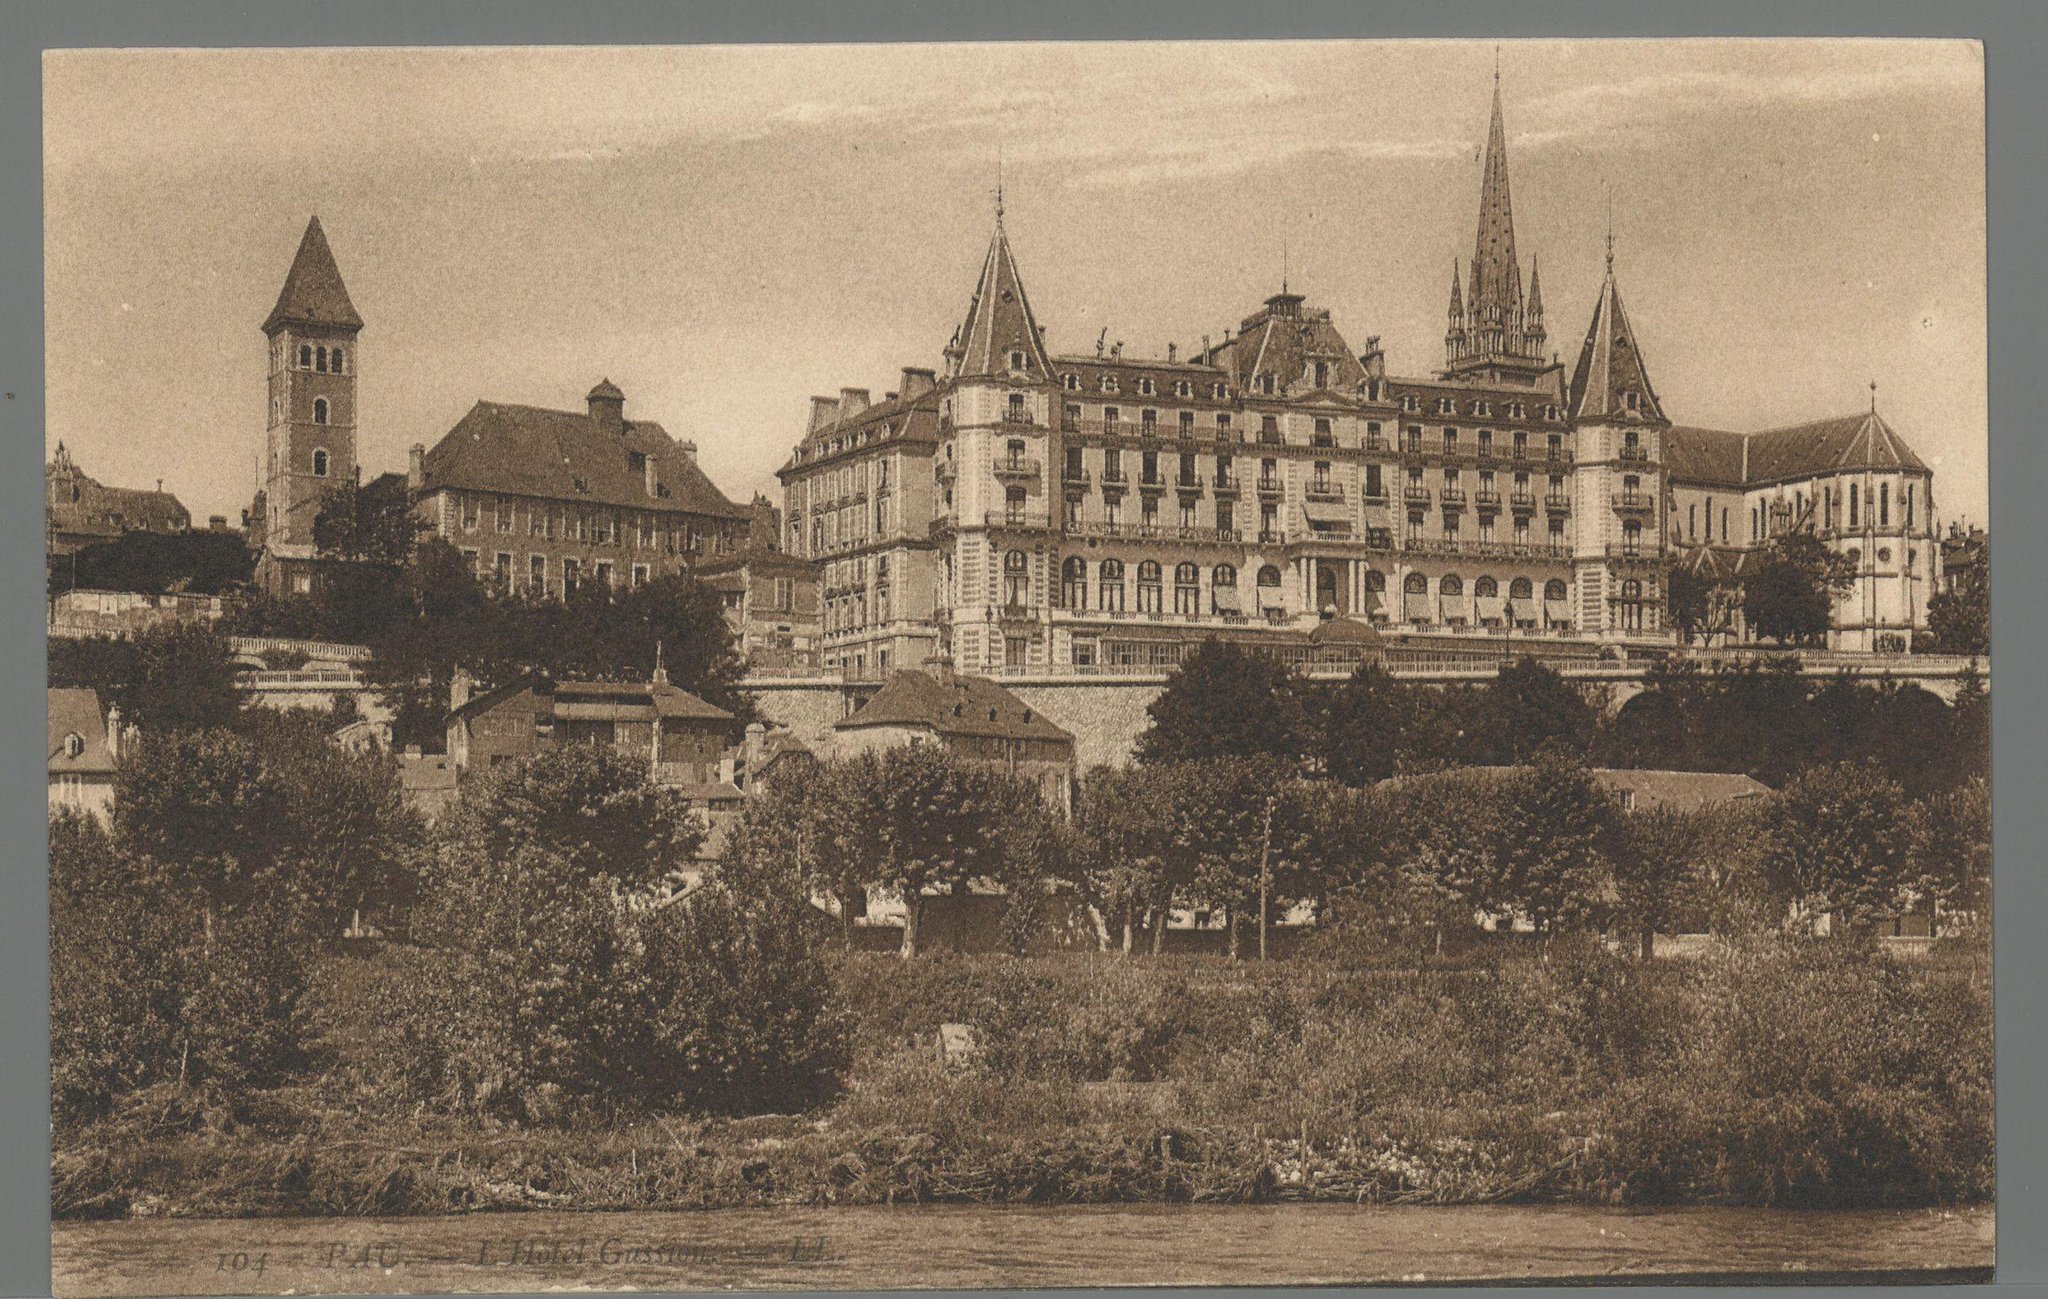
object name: photomechanical print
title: Pau. L'Hôtel Gassion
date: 1904-1906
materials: cardboard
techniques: photograph, writing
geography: paris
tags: city-view, and landscape with man-made constructions, church (exterior), hotel, hostelry, inn